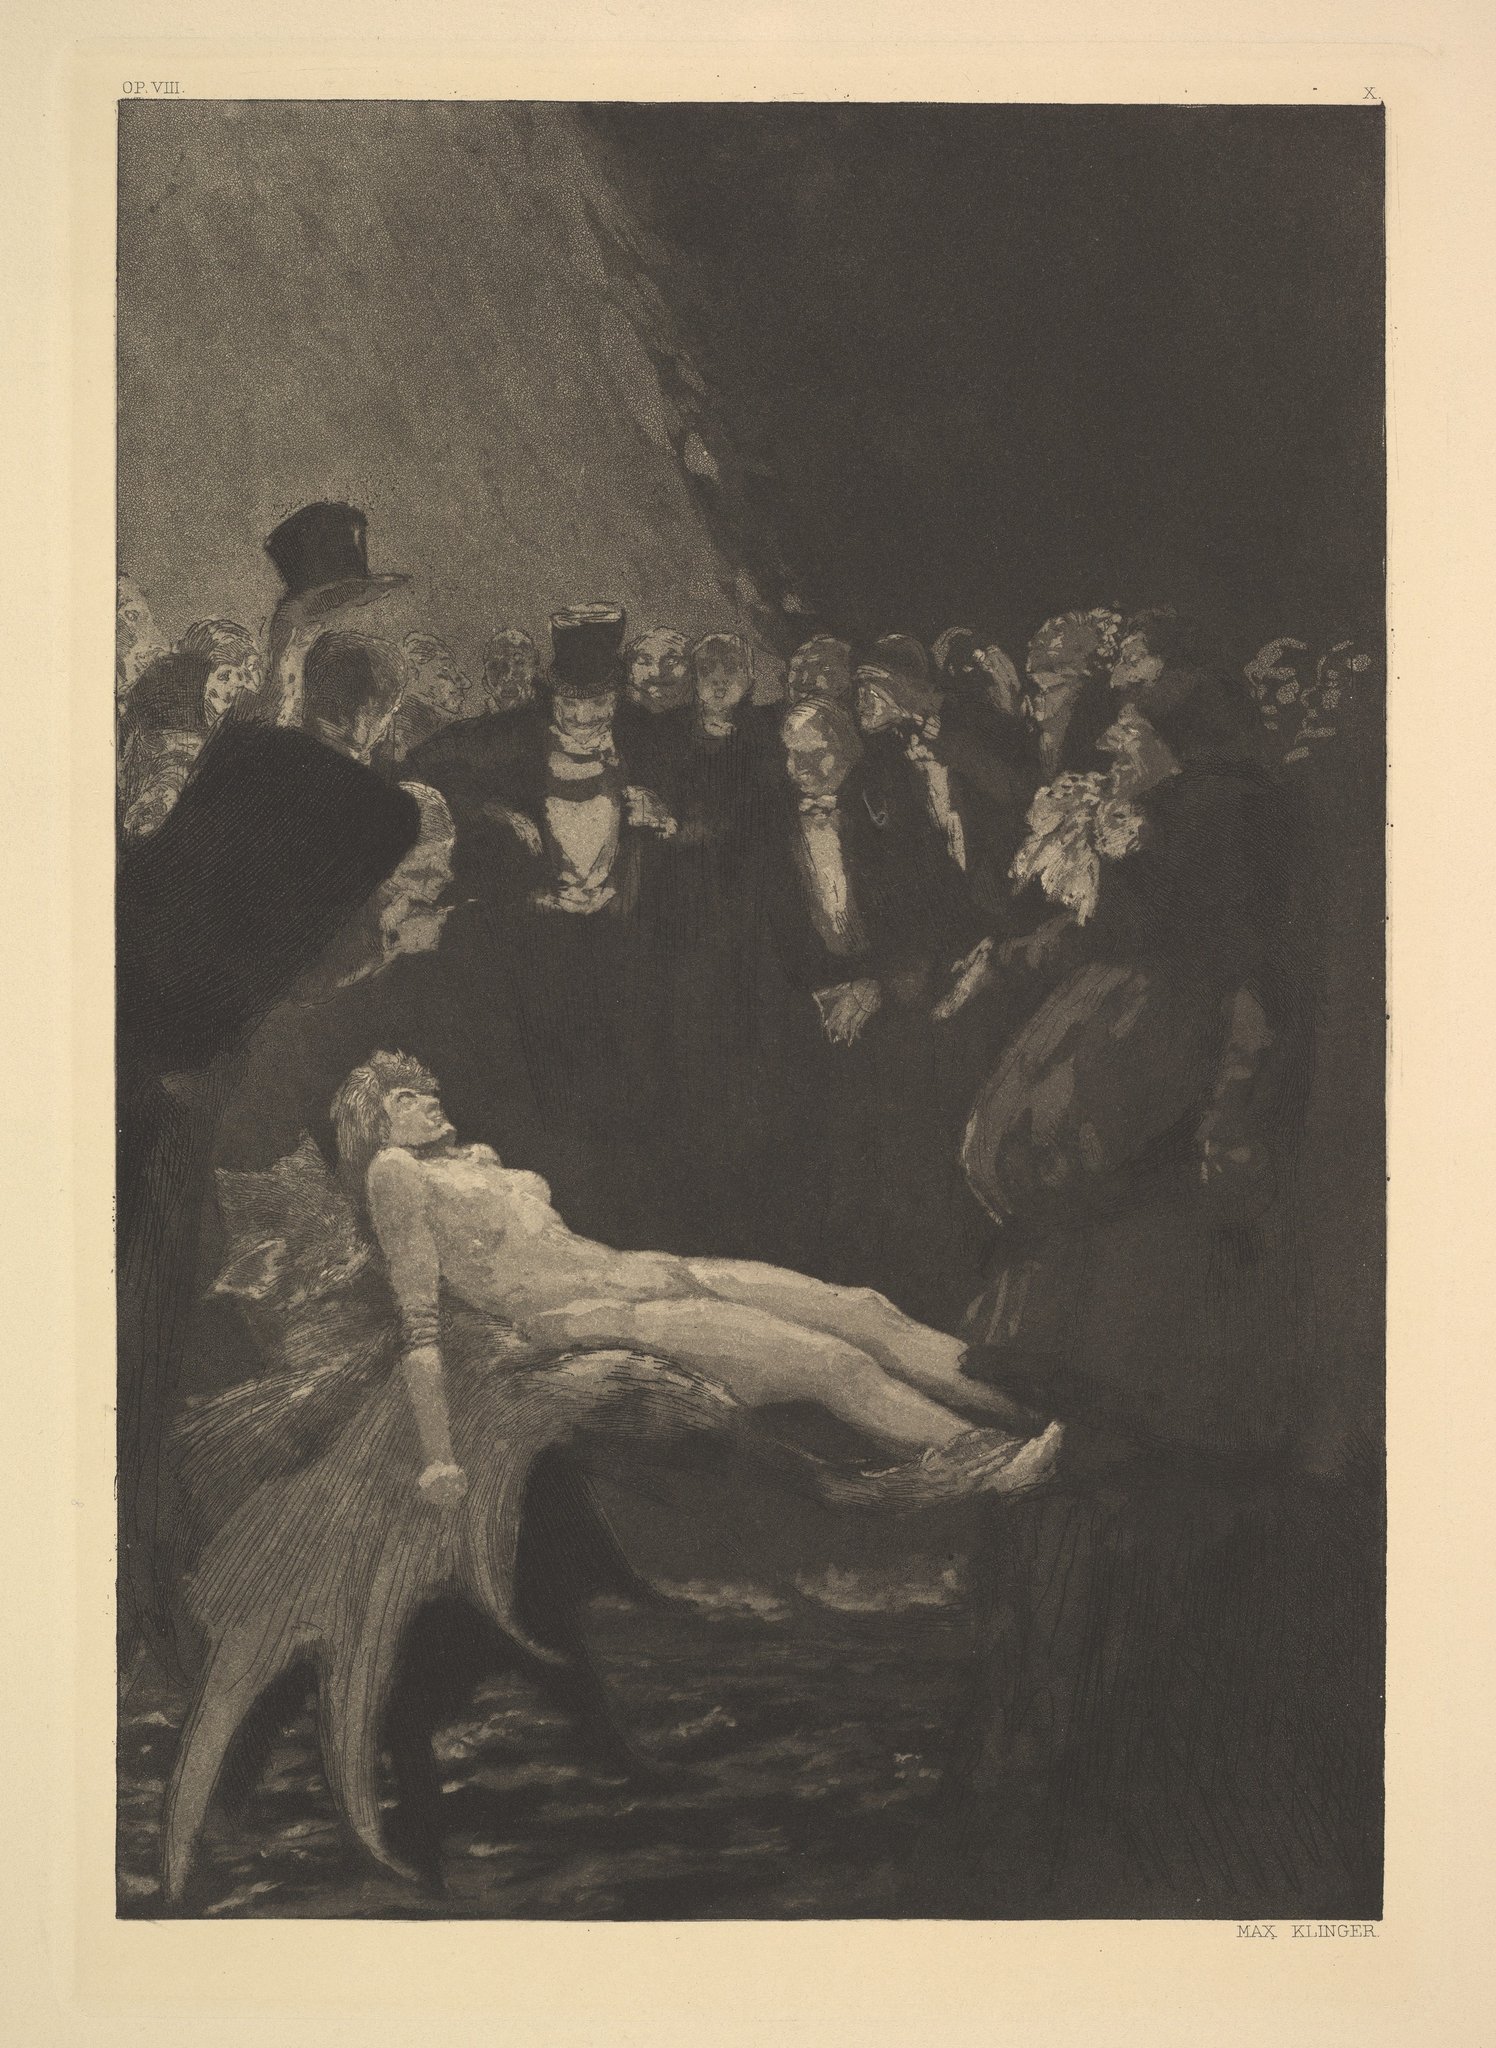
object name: portfolio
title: A Life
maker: max klinger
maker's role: artist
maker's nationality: german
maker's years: 1857-1920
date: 1884-1898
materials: cardboard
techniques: etching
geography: germany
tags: female nudes,crowd